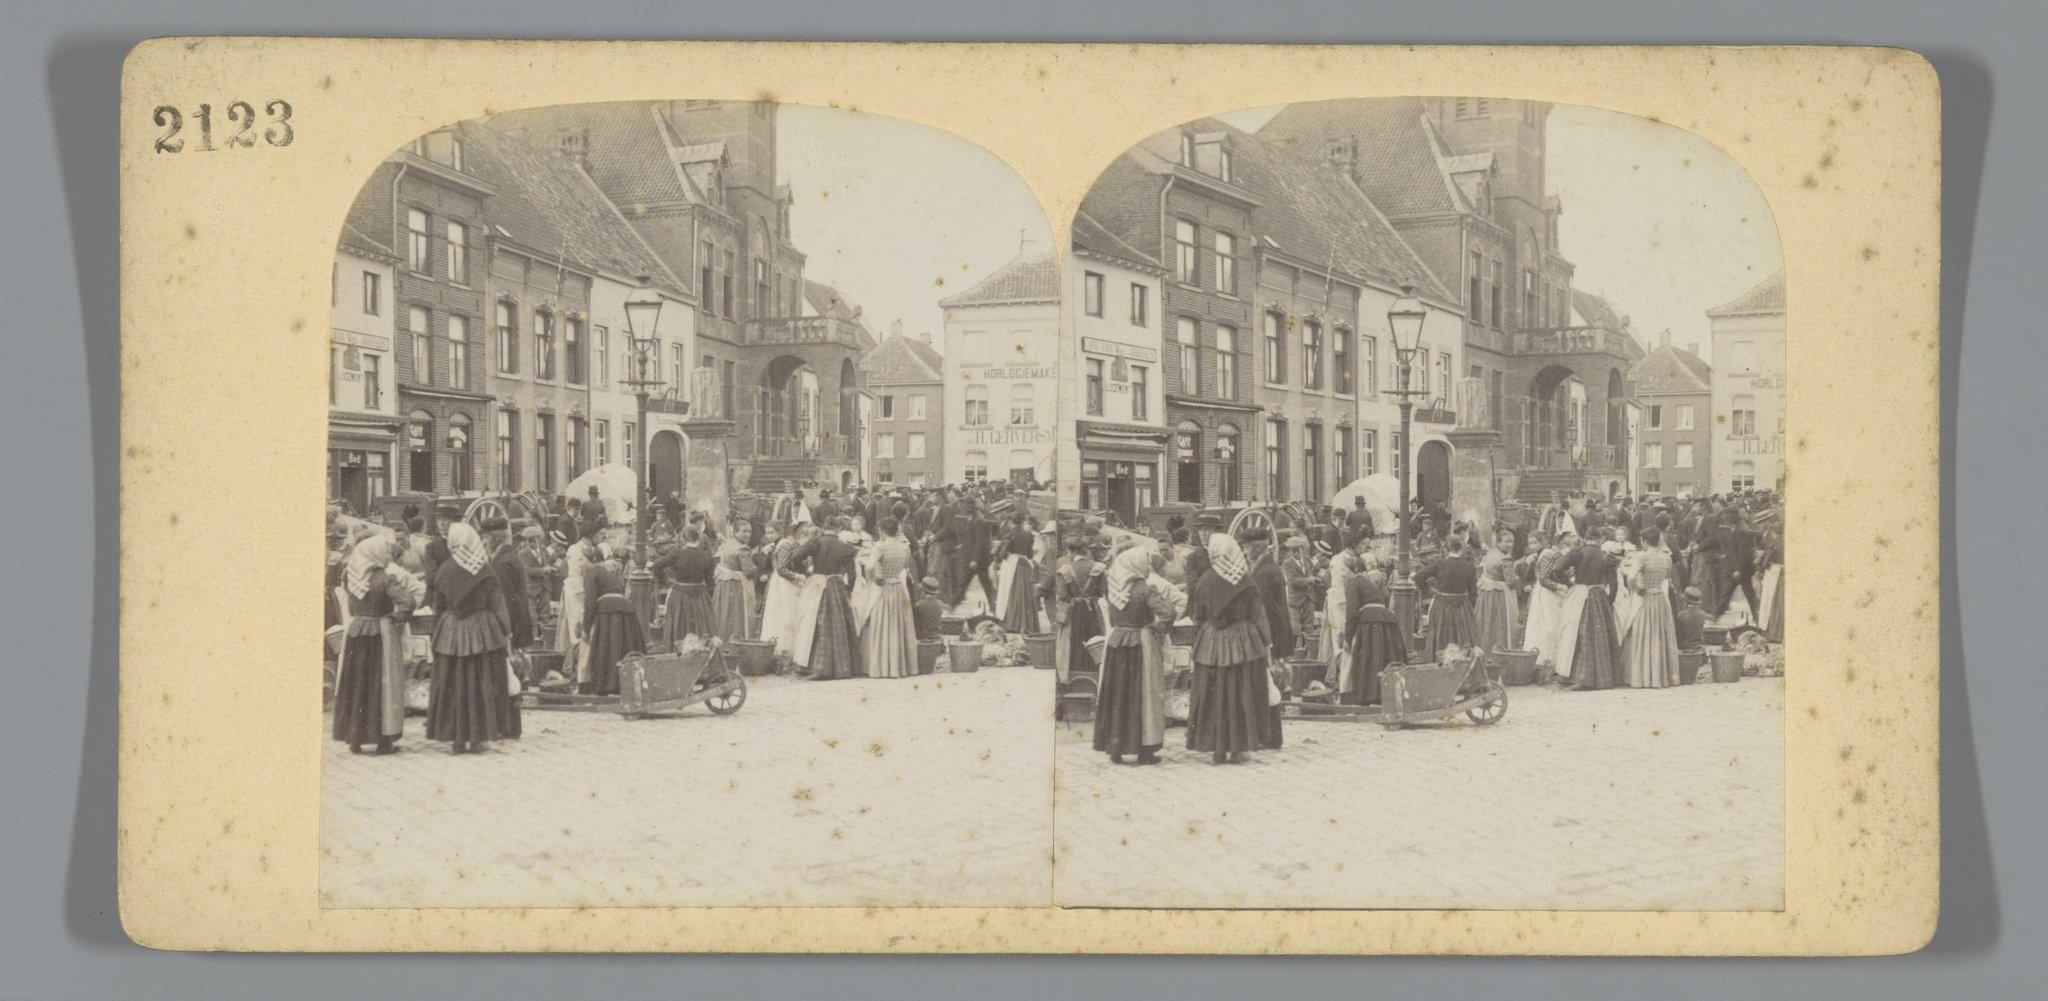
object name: stereograph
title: Markttafereel op de Markt in Sittard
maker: Anonymous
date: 1879-1910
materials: cardboard, paper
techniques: albumen print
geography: sittard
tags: market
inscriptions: number: ‘2123’